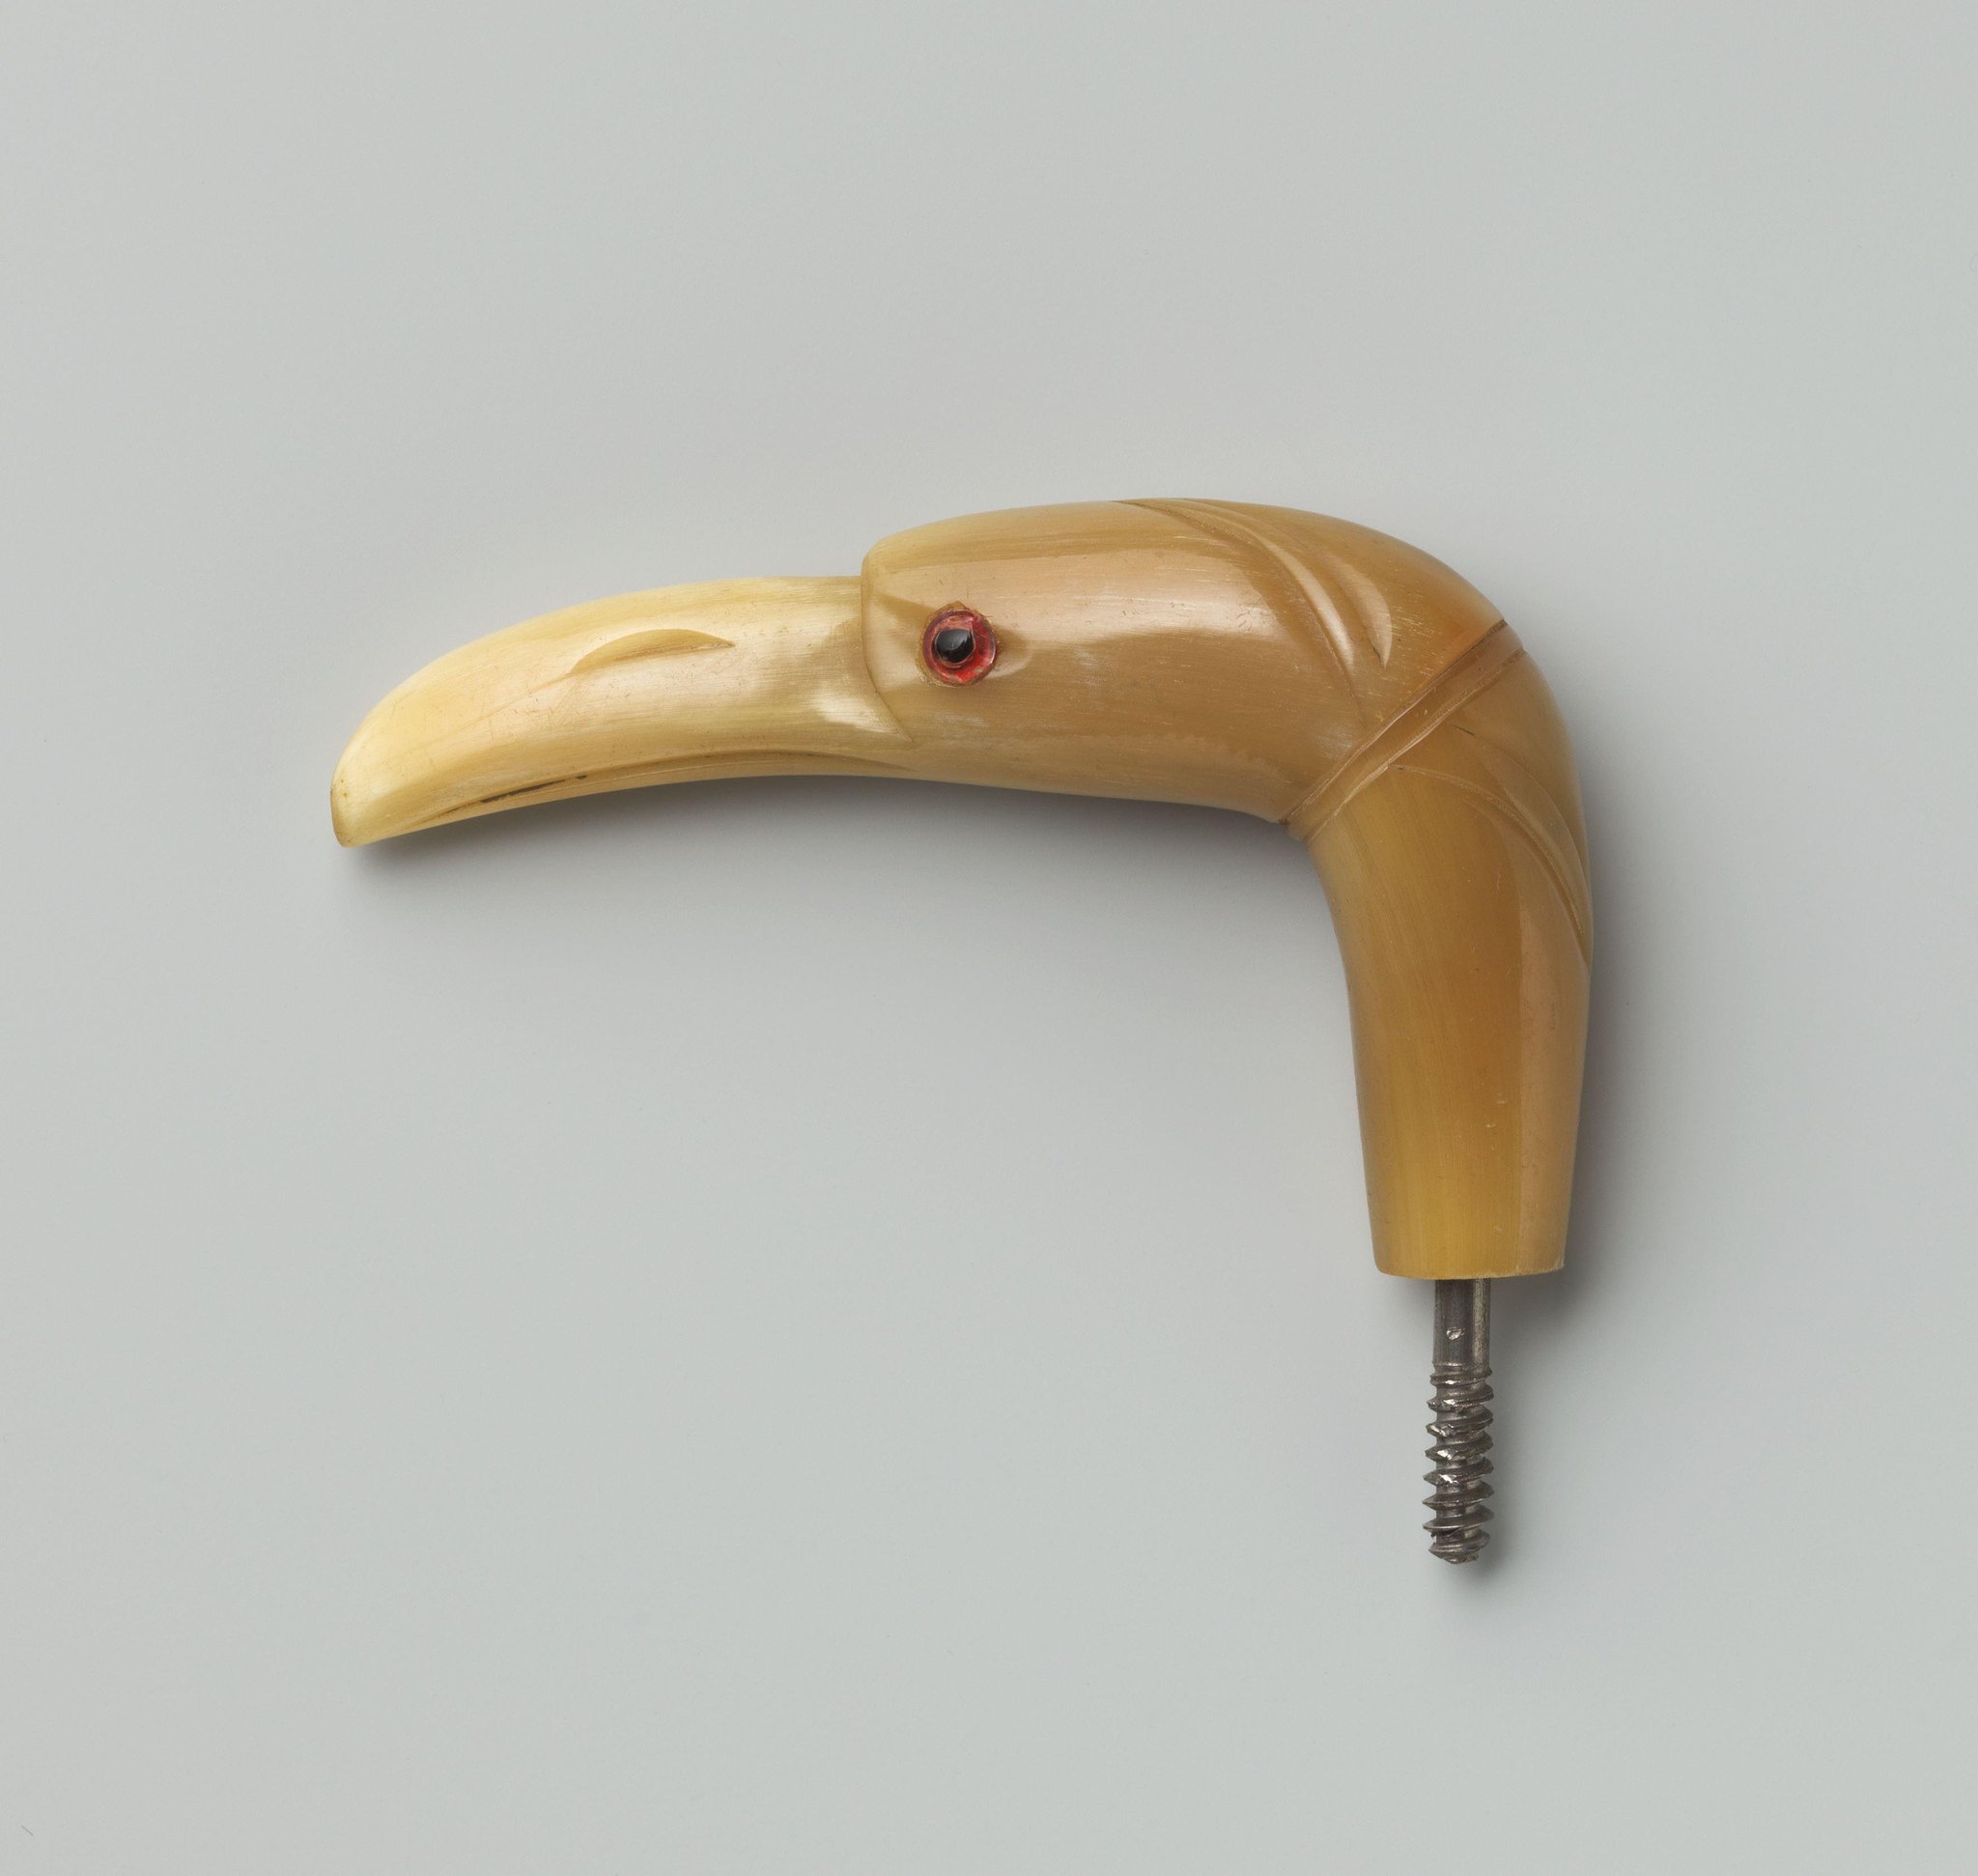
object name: handle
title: Knop van beige hoorn in de vorm van een vogelkop met iets geronde, spitse snavel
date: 1900-1930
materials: glass, horn, metal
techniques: manufacturing, casting, cutting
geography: netherlands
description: Knop van beige hoorn in de vorm van een vogelkop met iets geronde, spitse snavel, en roodroze ogen van glas. Aan de achterkant van de hals een diamantvormige inkerving. Met schroefdraad.